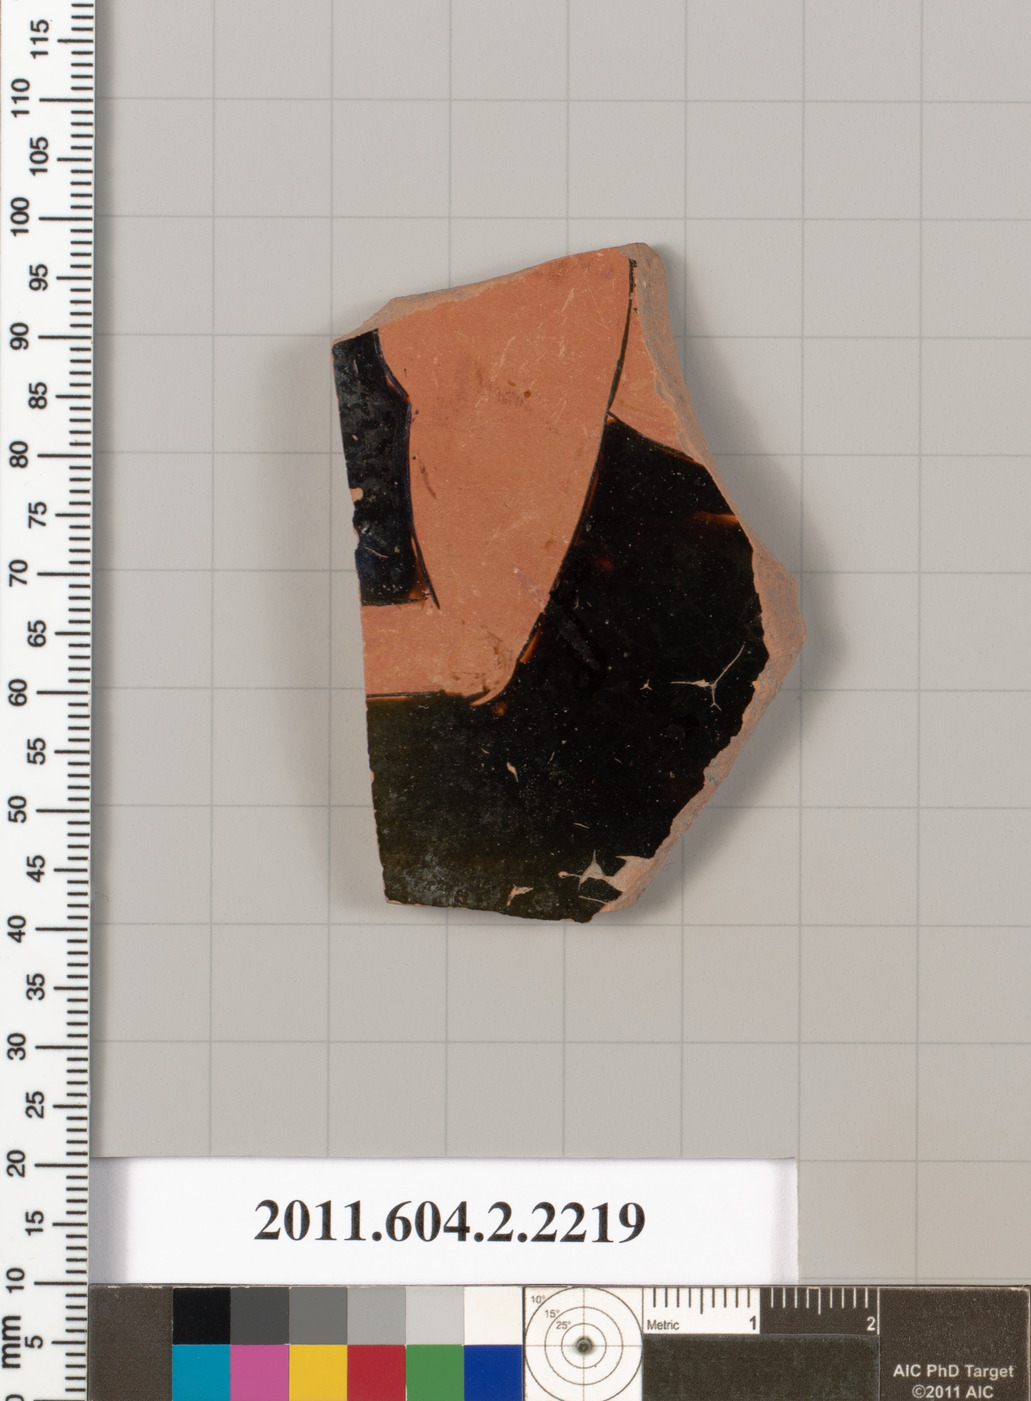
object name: pot fragment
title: Terracotta fragment of a pot; unglazed on the inside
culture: greek, attic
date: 475-451 BCE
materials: terracotta